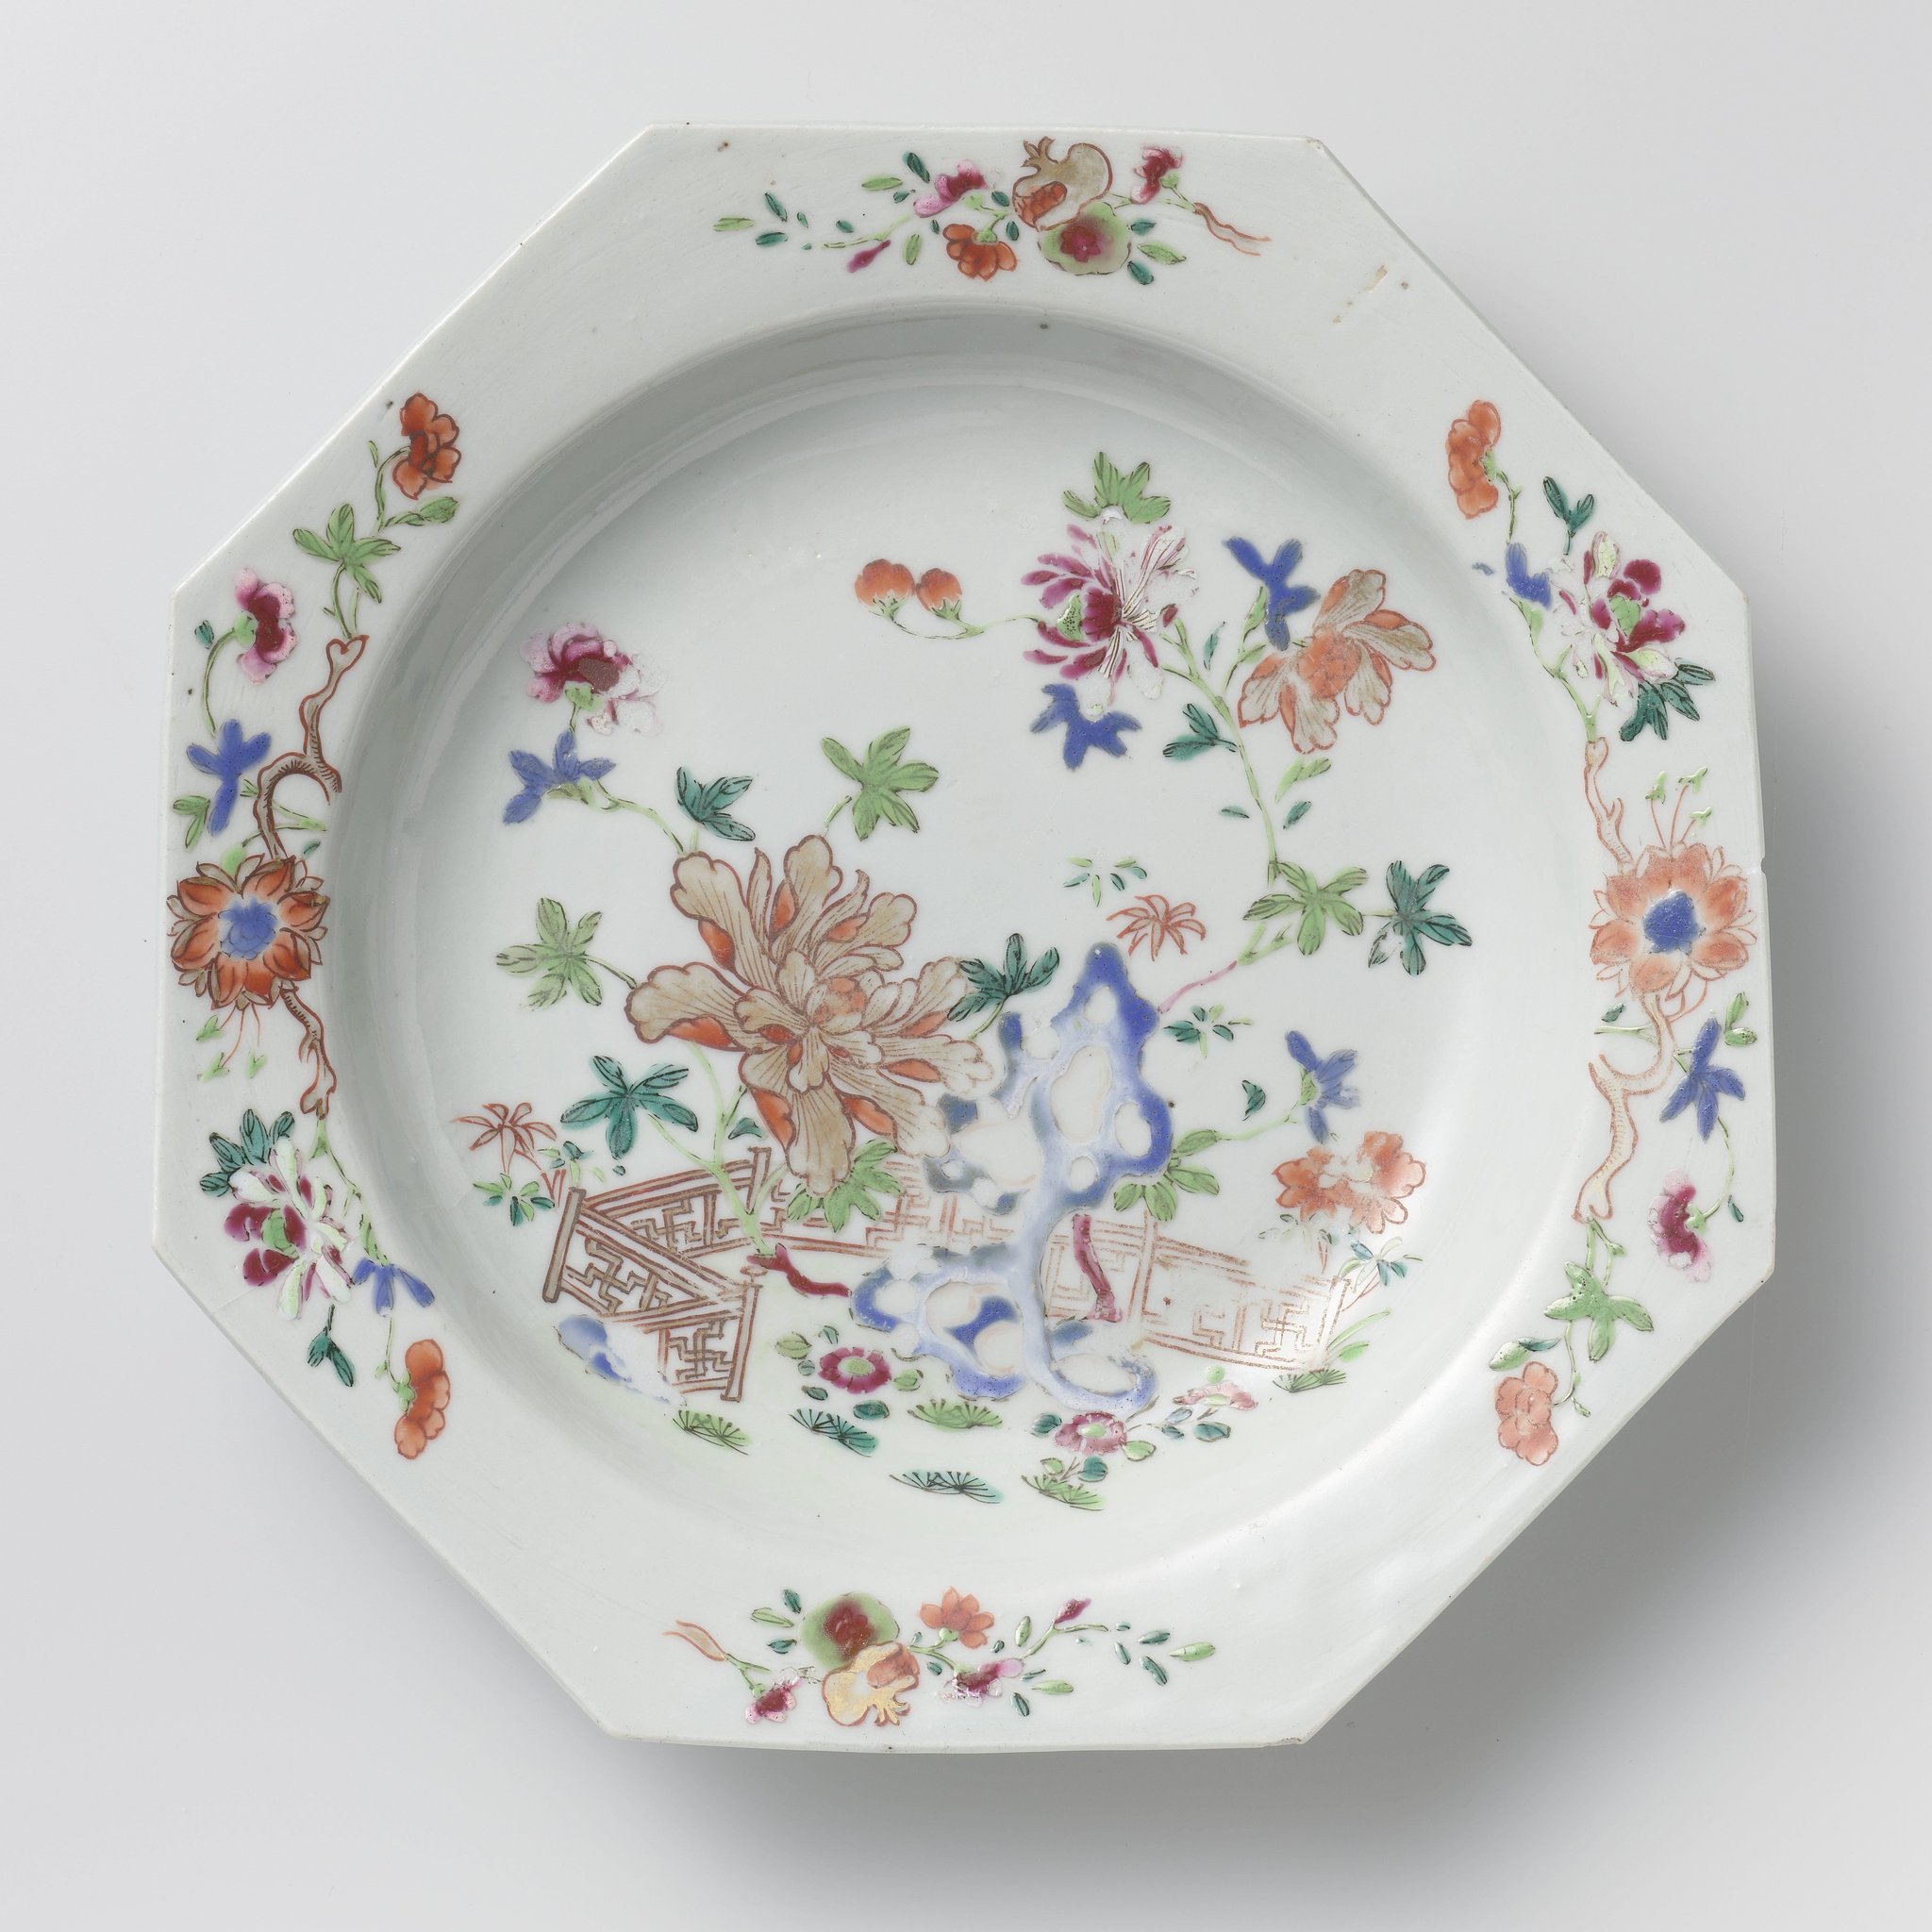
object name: soup plate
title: Octagonal soup plate with a rock, flowering plants and a fence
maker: Anonymous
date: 1725-1749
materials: glaze, gold, paint, porcelain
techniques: firing, forming, gilding, turning, vitrification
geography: china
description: Achthoekig soepbord van porselein, beschilderd op het glazuur in blauw, rood, roze, groen, zwart en goud. Op het plat een rots met bloeiende planten en een hek; de rand met vier takken met bloemen en vruchten. Een chip en twee barsten in de rand. Famille rose.